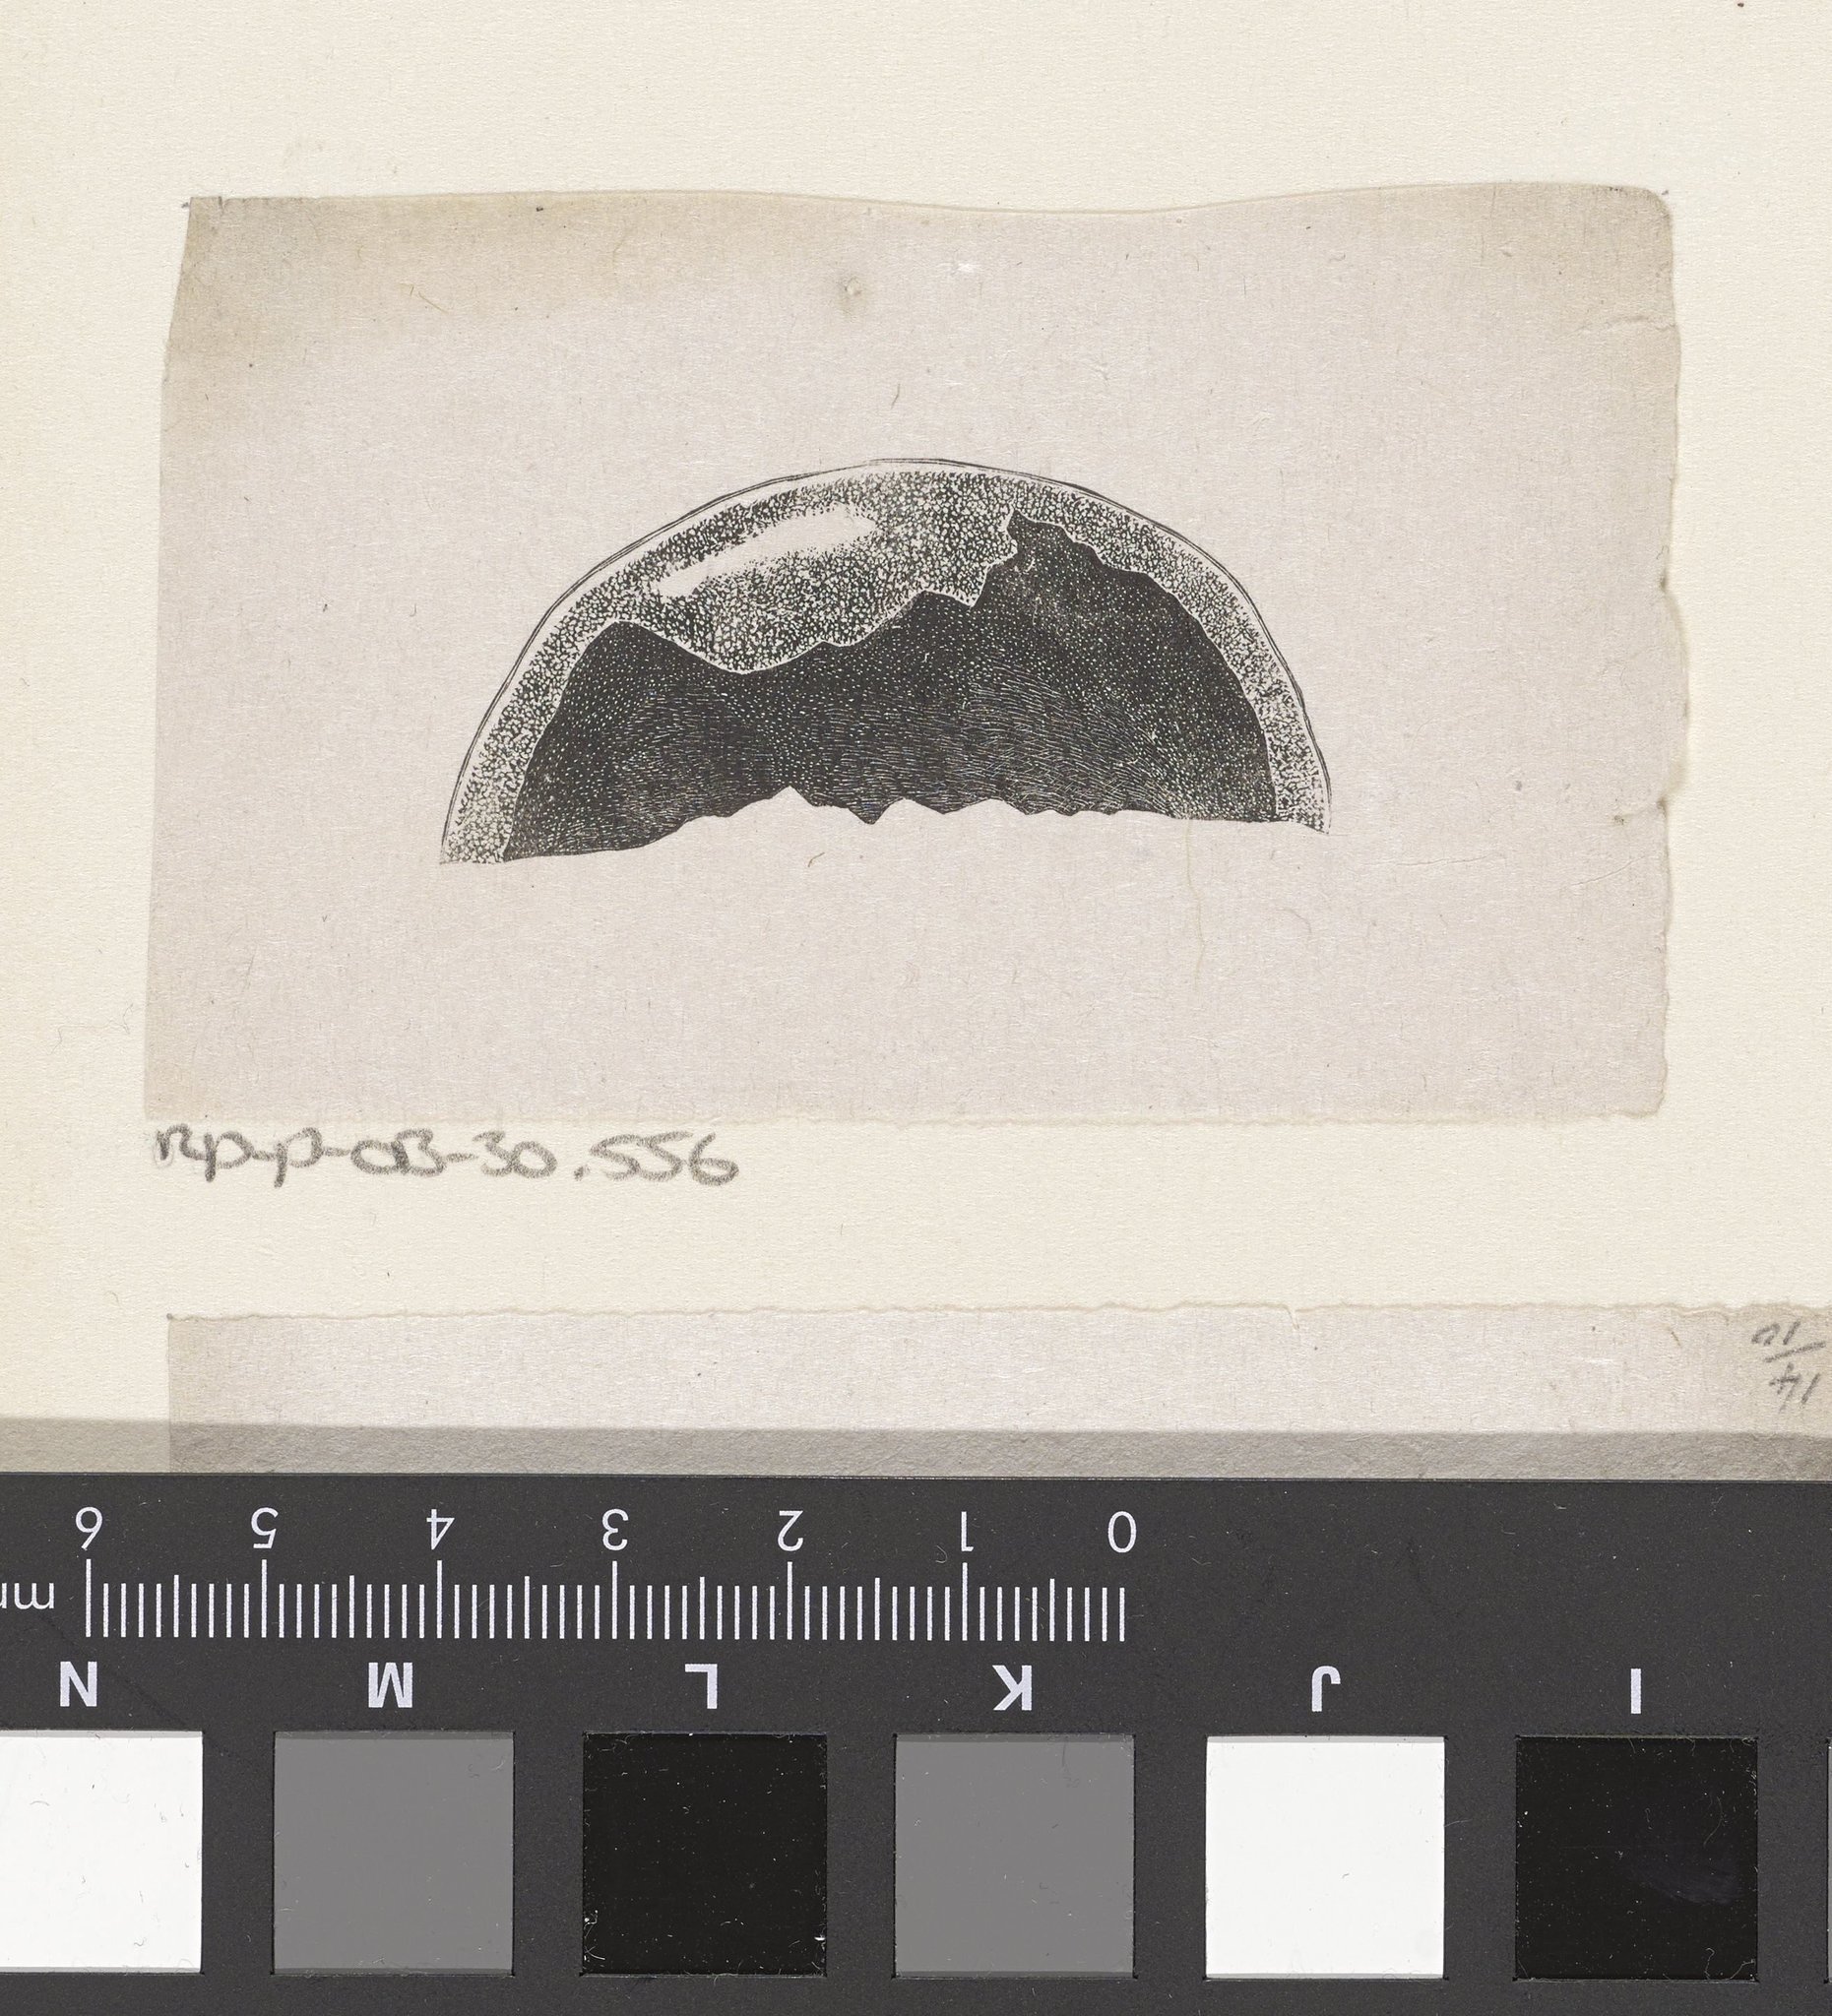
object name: print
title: Menselijke schedel met een afwijking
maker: isaac weissenbruch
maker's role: print maker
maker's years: 1826-1912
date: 1836-1912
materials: paper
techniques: engraving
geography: netherlands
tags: (human) skull, diseases